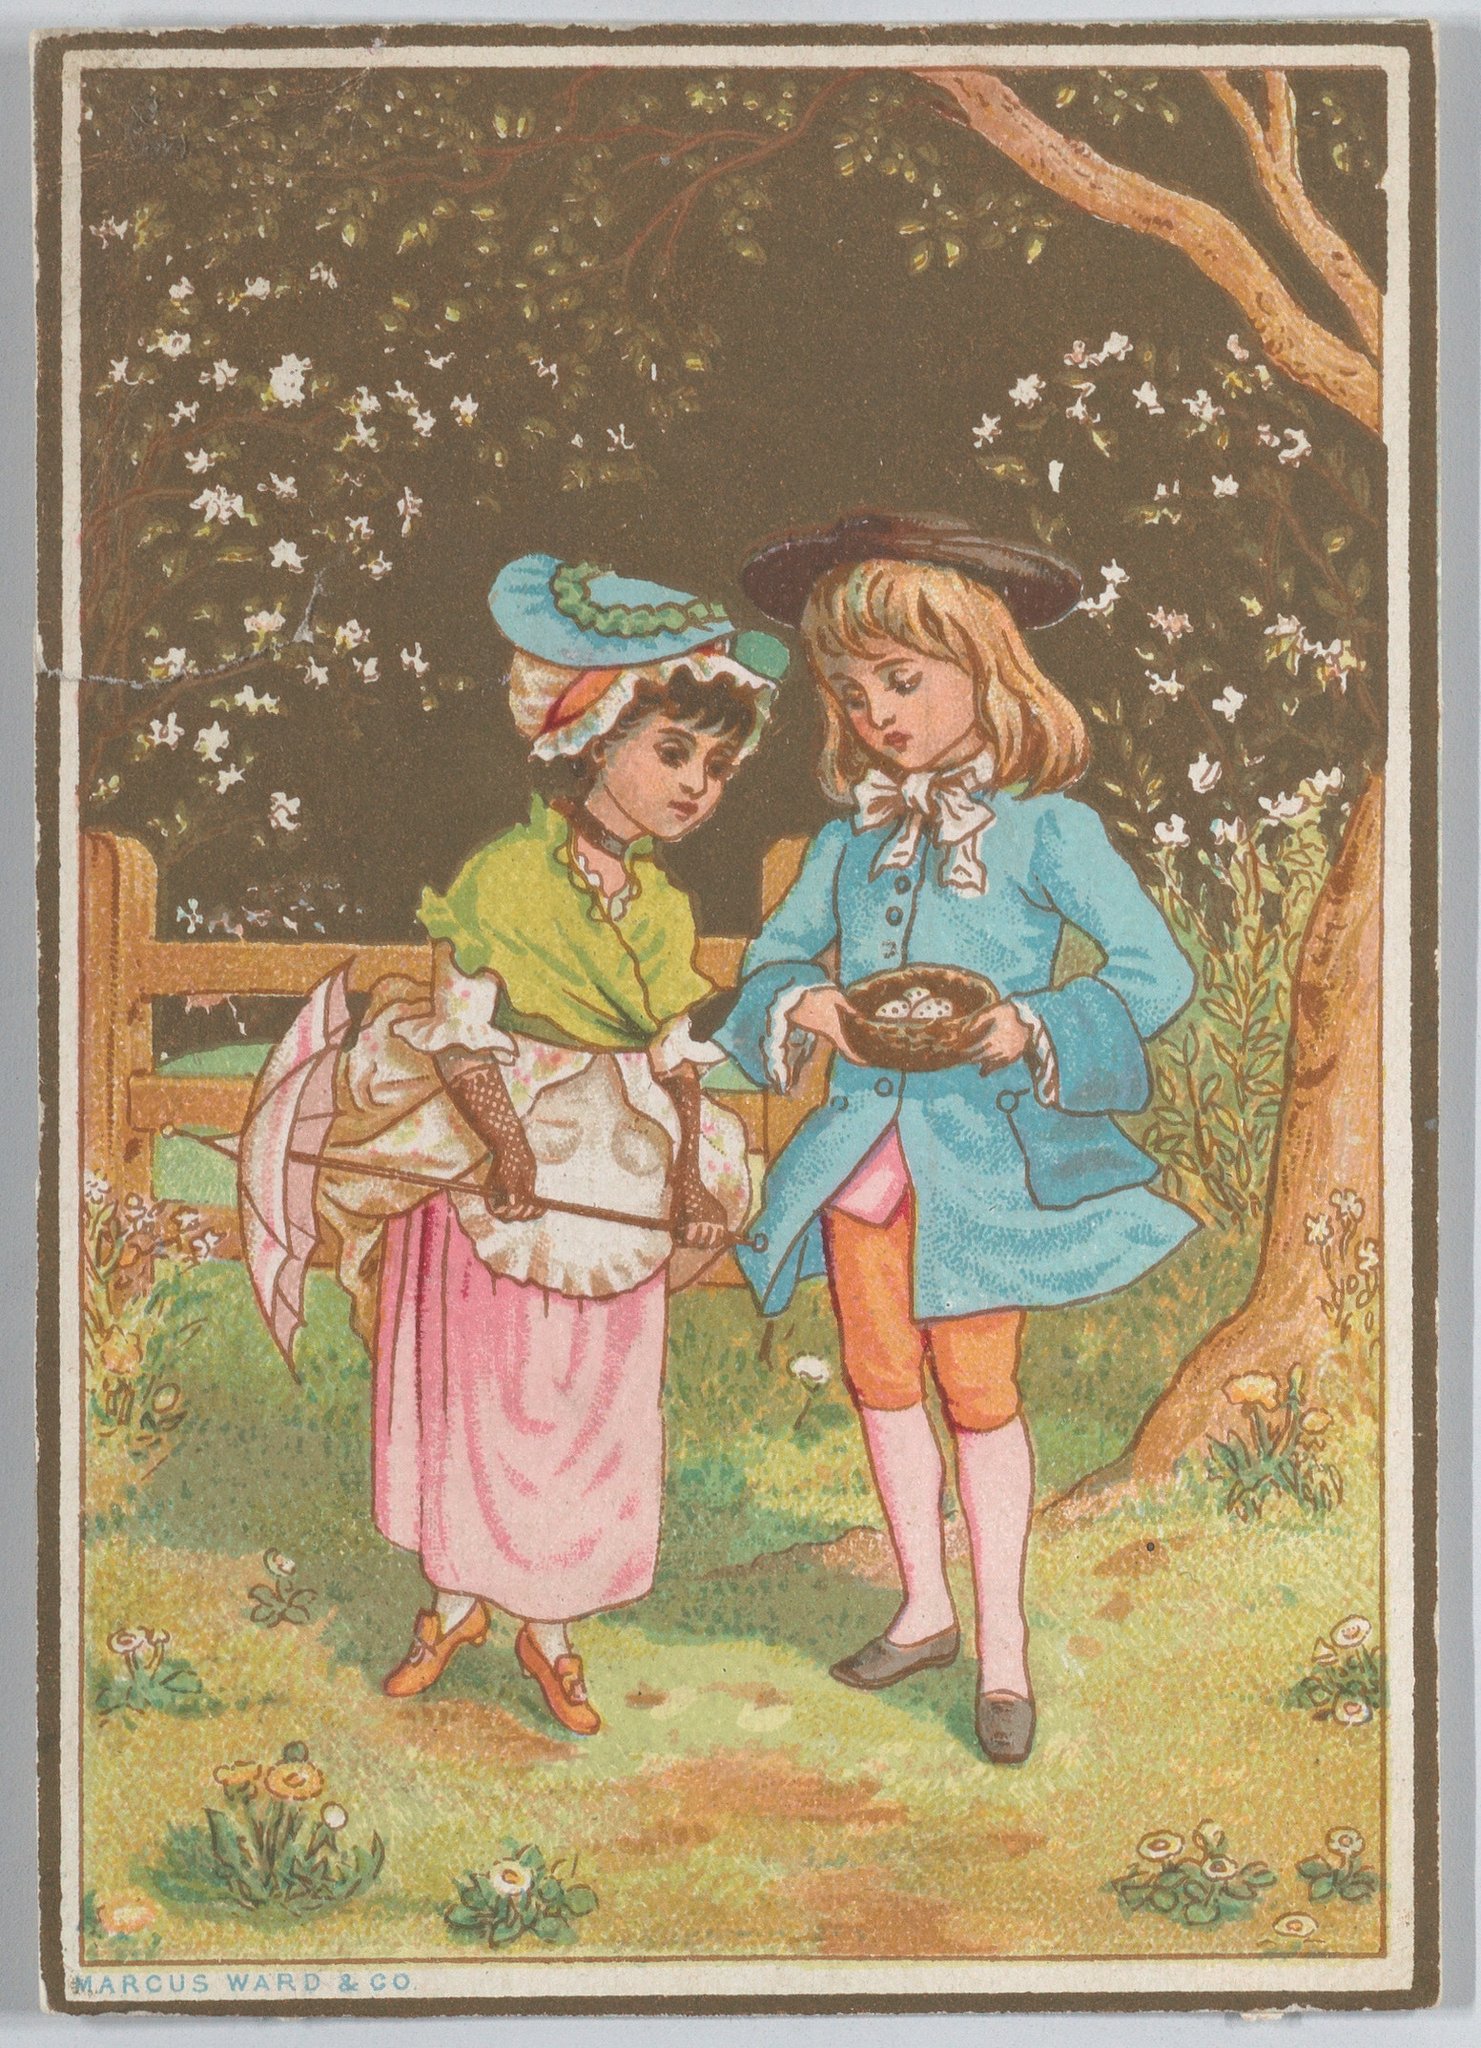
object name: valentine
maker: kate greenaway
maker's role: artist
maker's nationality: british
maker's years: 1846-1901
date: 1880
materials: gold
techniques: chromolithography, gilding, lithograph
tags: boys,girls